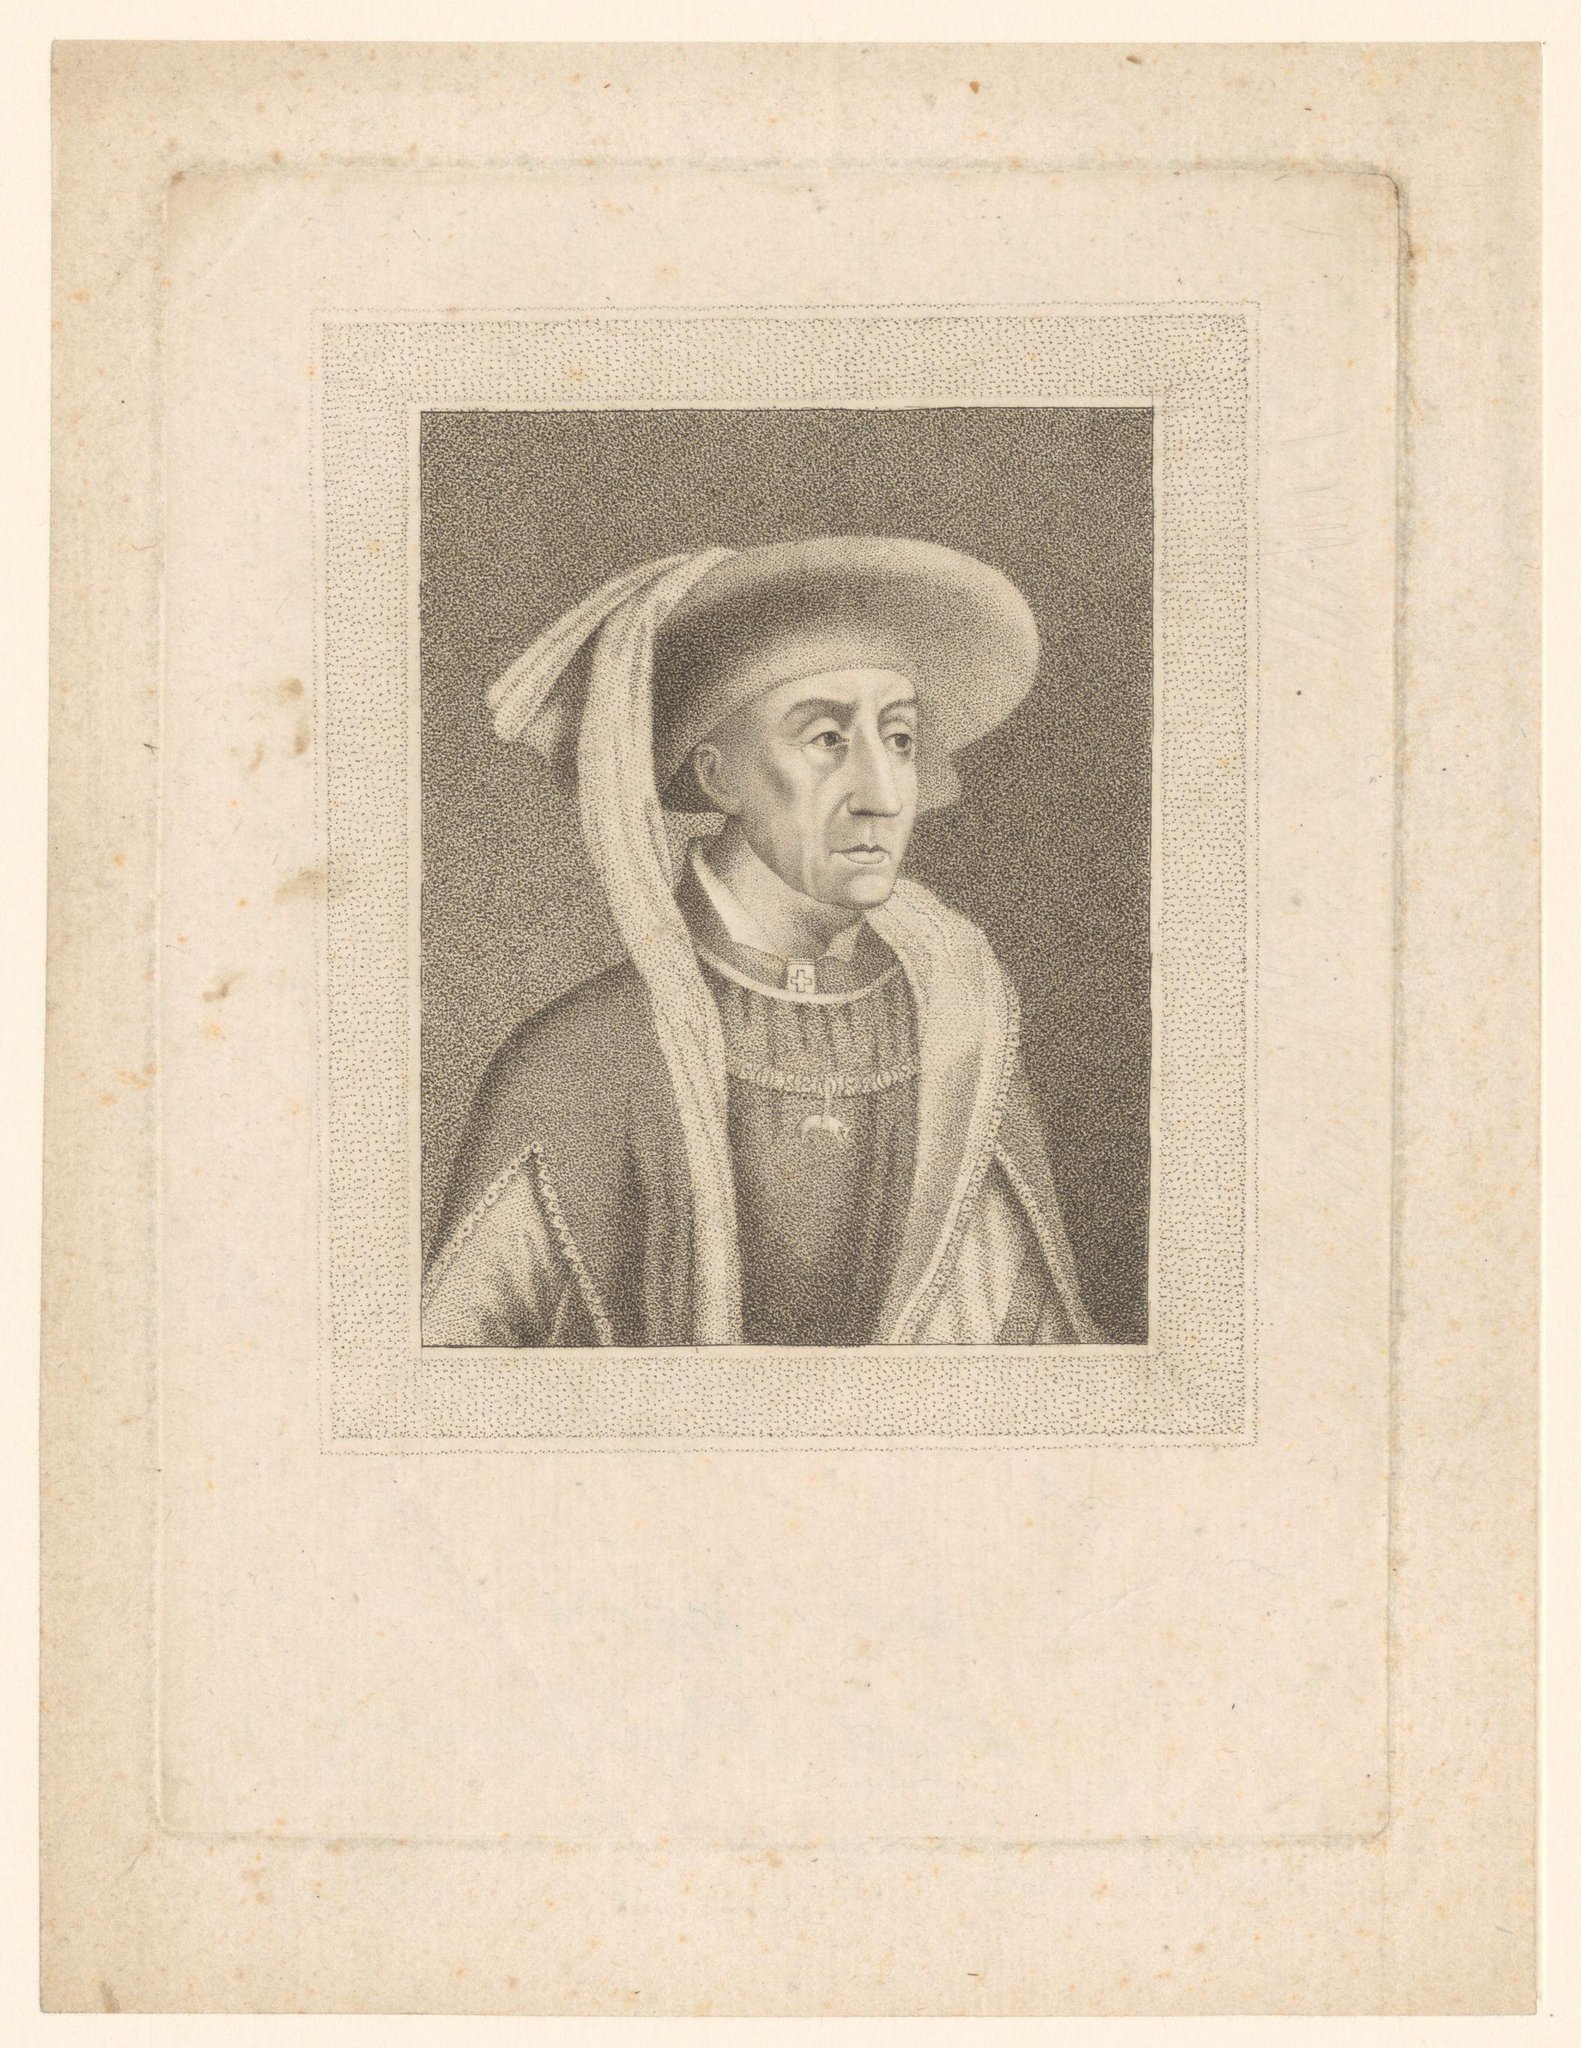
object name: print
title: Duke of Burgundy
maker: sylvester harding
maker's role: print maker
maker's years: 1745-1809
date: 1793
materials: paper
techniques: etching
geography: london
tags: william shakespeare, philip iii the good, historical persons, knighthood order of the golden fleece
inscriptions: collector's mark: Lugt 2228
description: Latere staat van prent gebruikt in: Shak[e]speare Illustrated (...). Londen: Sylvester en Edward Harding, 1793.